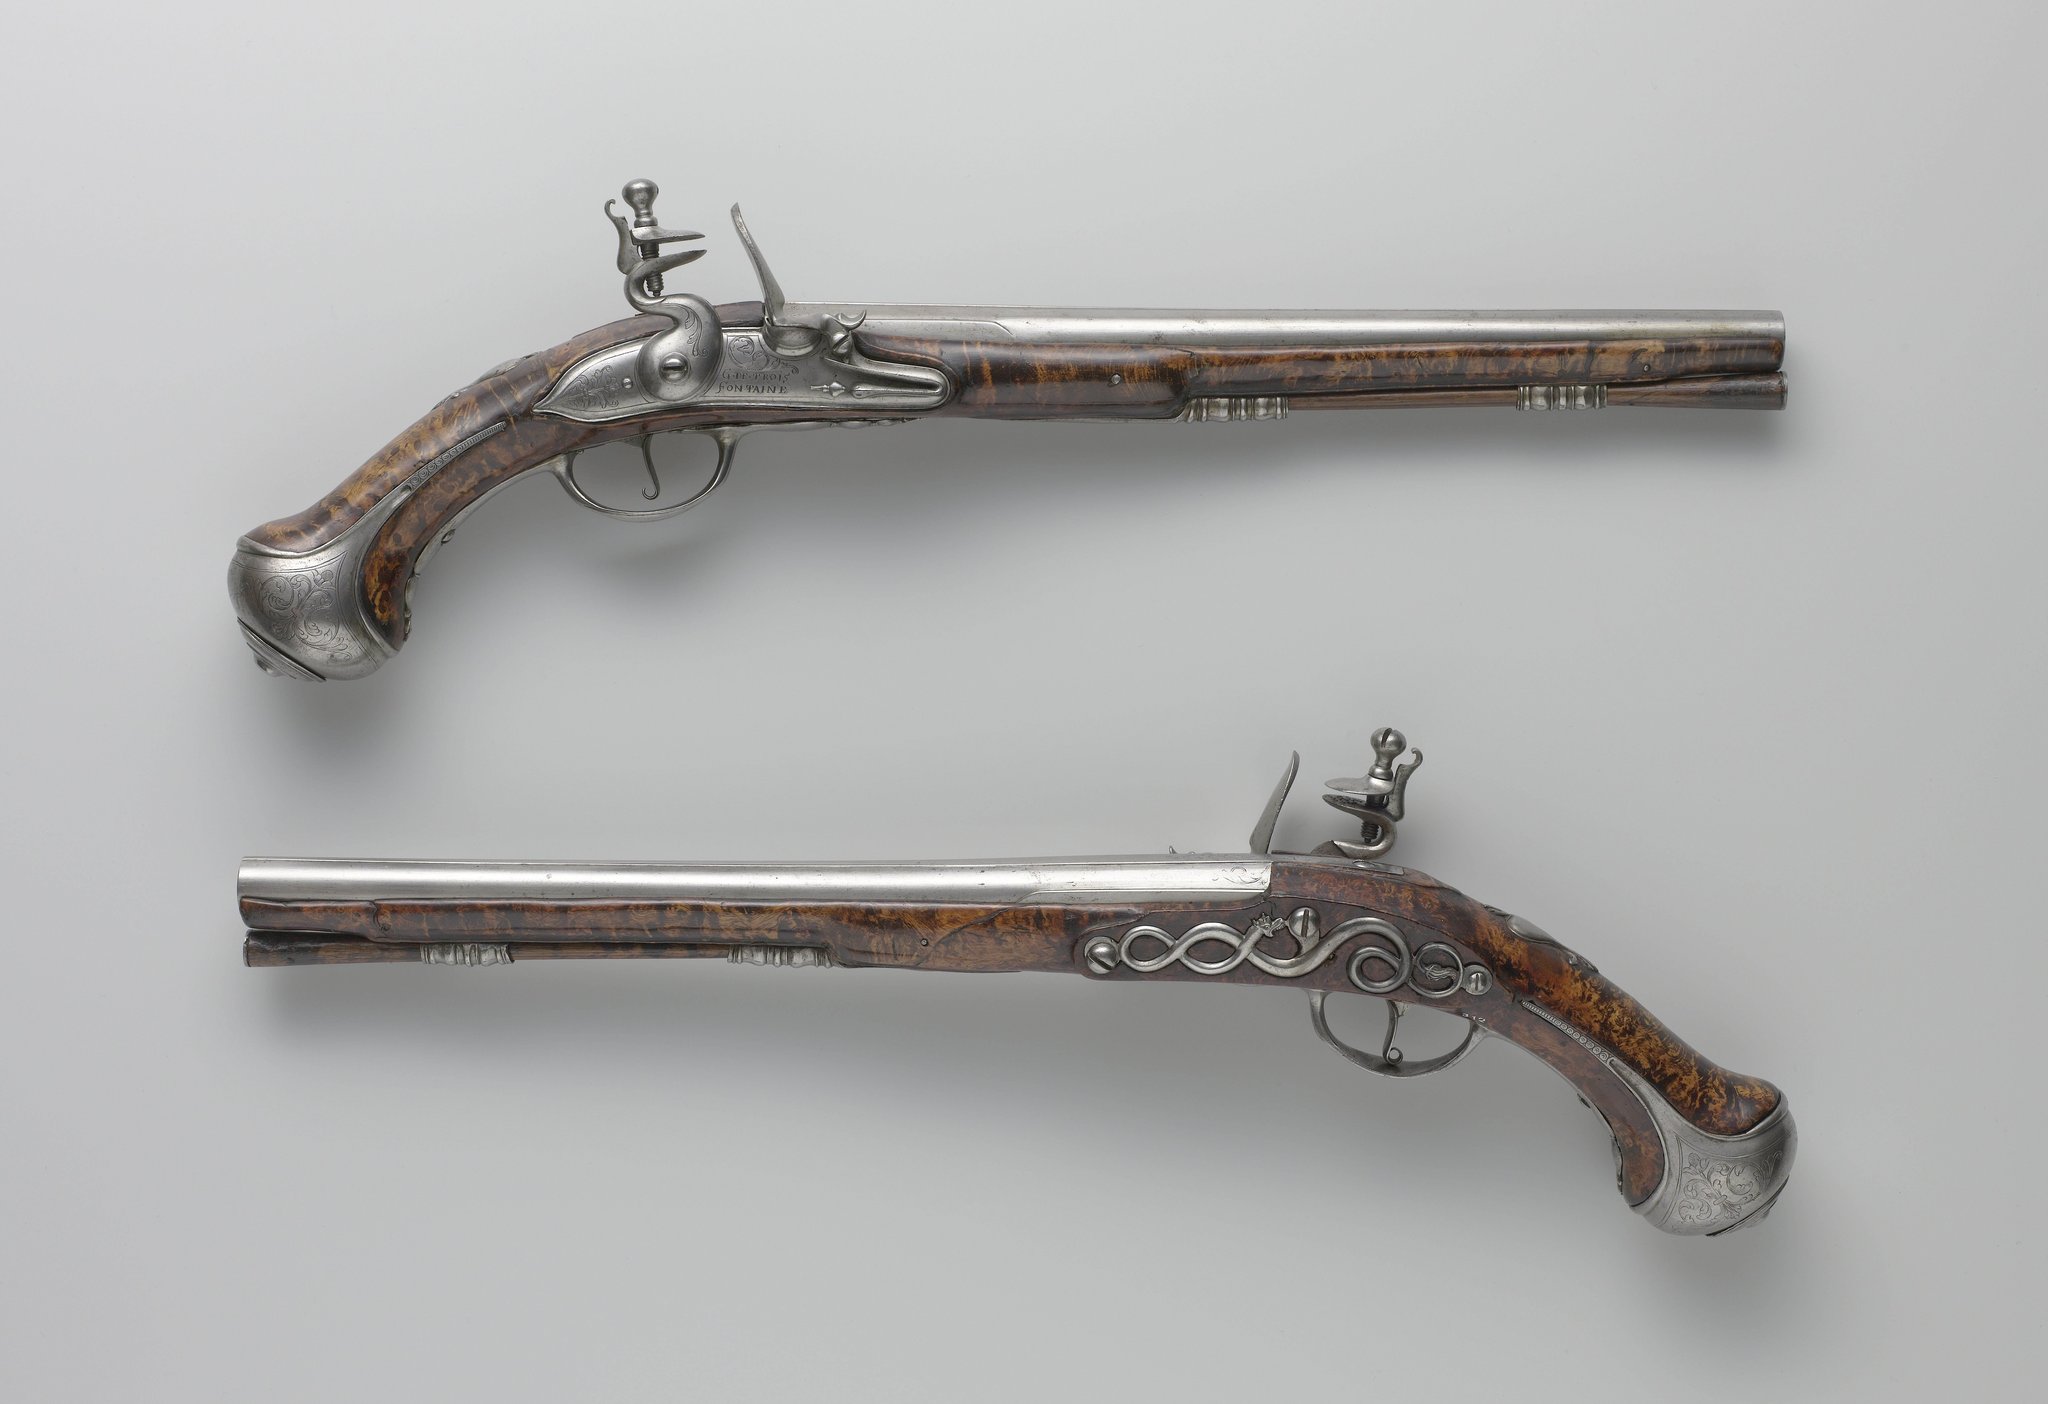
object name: flintlock pistol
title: Vuursteenpistool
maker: g. de trois fontaines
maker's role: geweermaker, pistoolmaker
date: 1680-1690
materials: iron, wood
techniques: cutting, engraving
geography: blégny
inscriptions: mark, inscription: ‘G.DE.TROIS // FONTAINE’